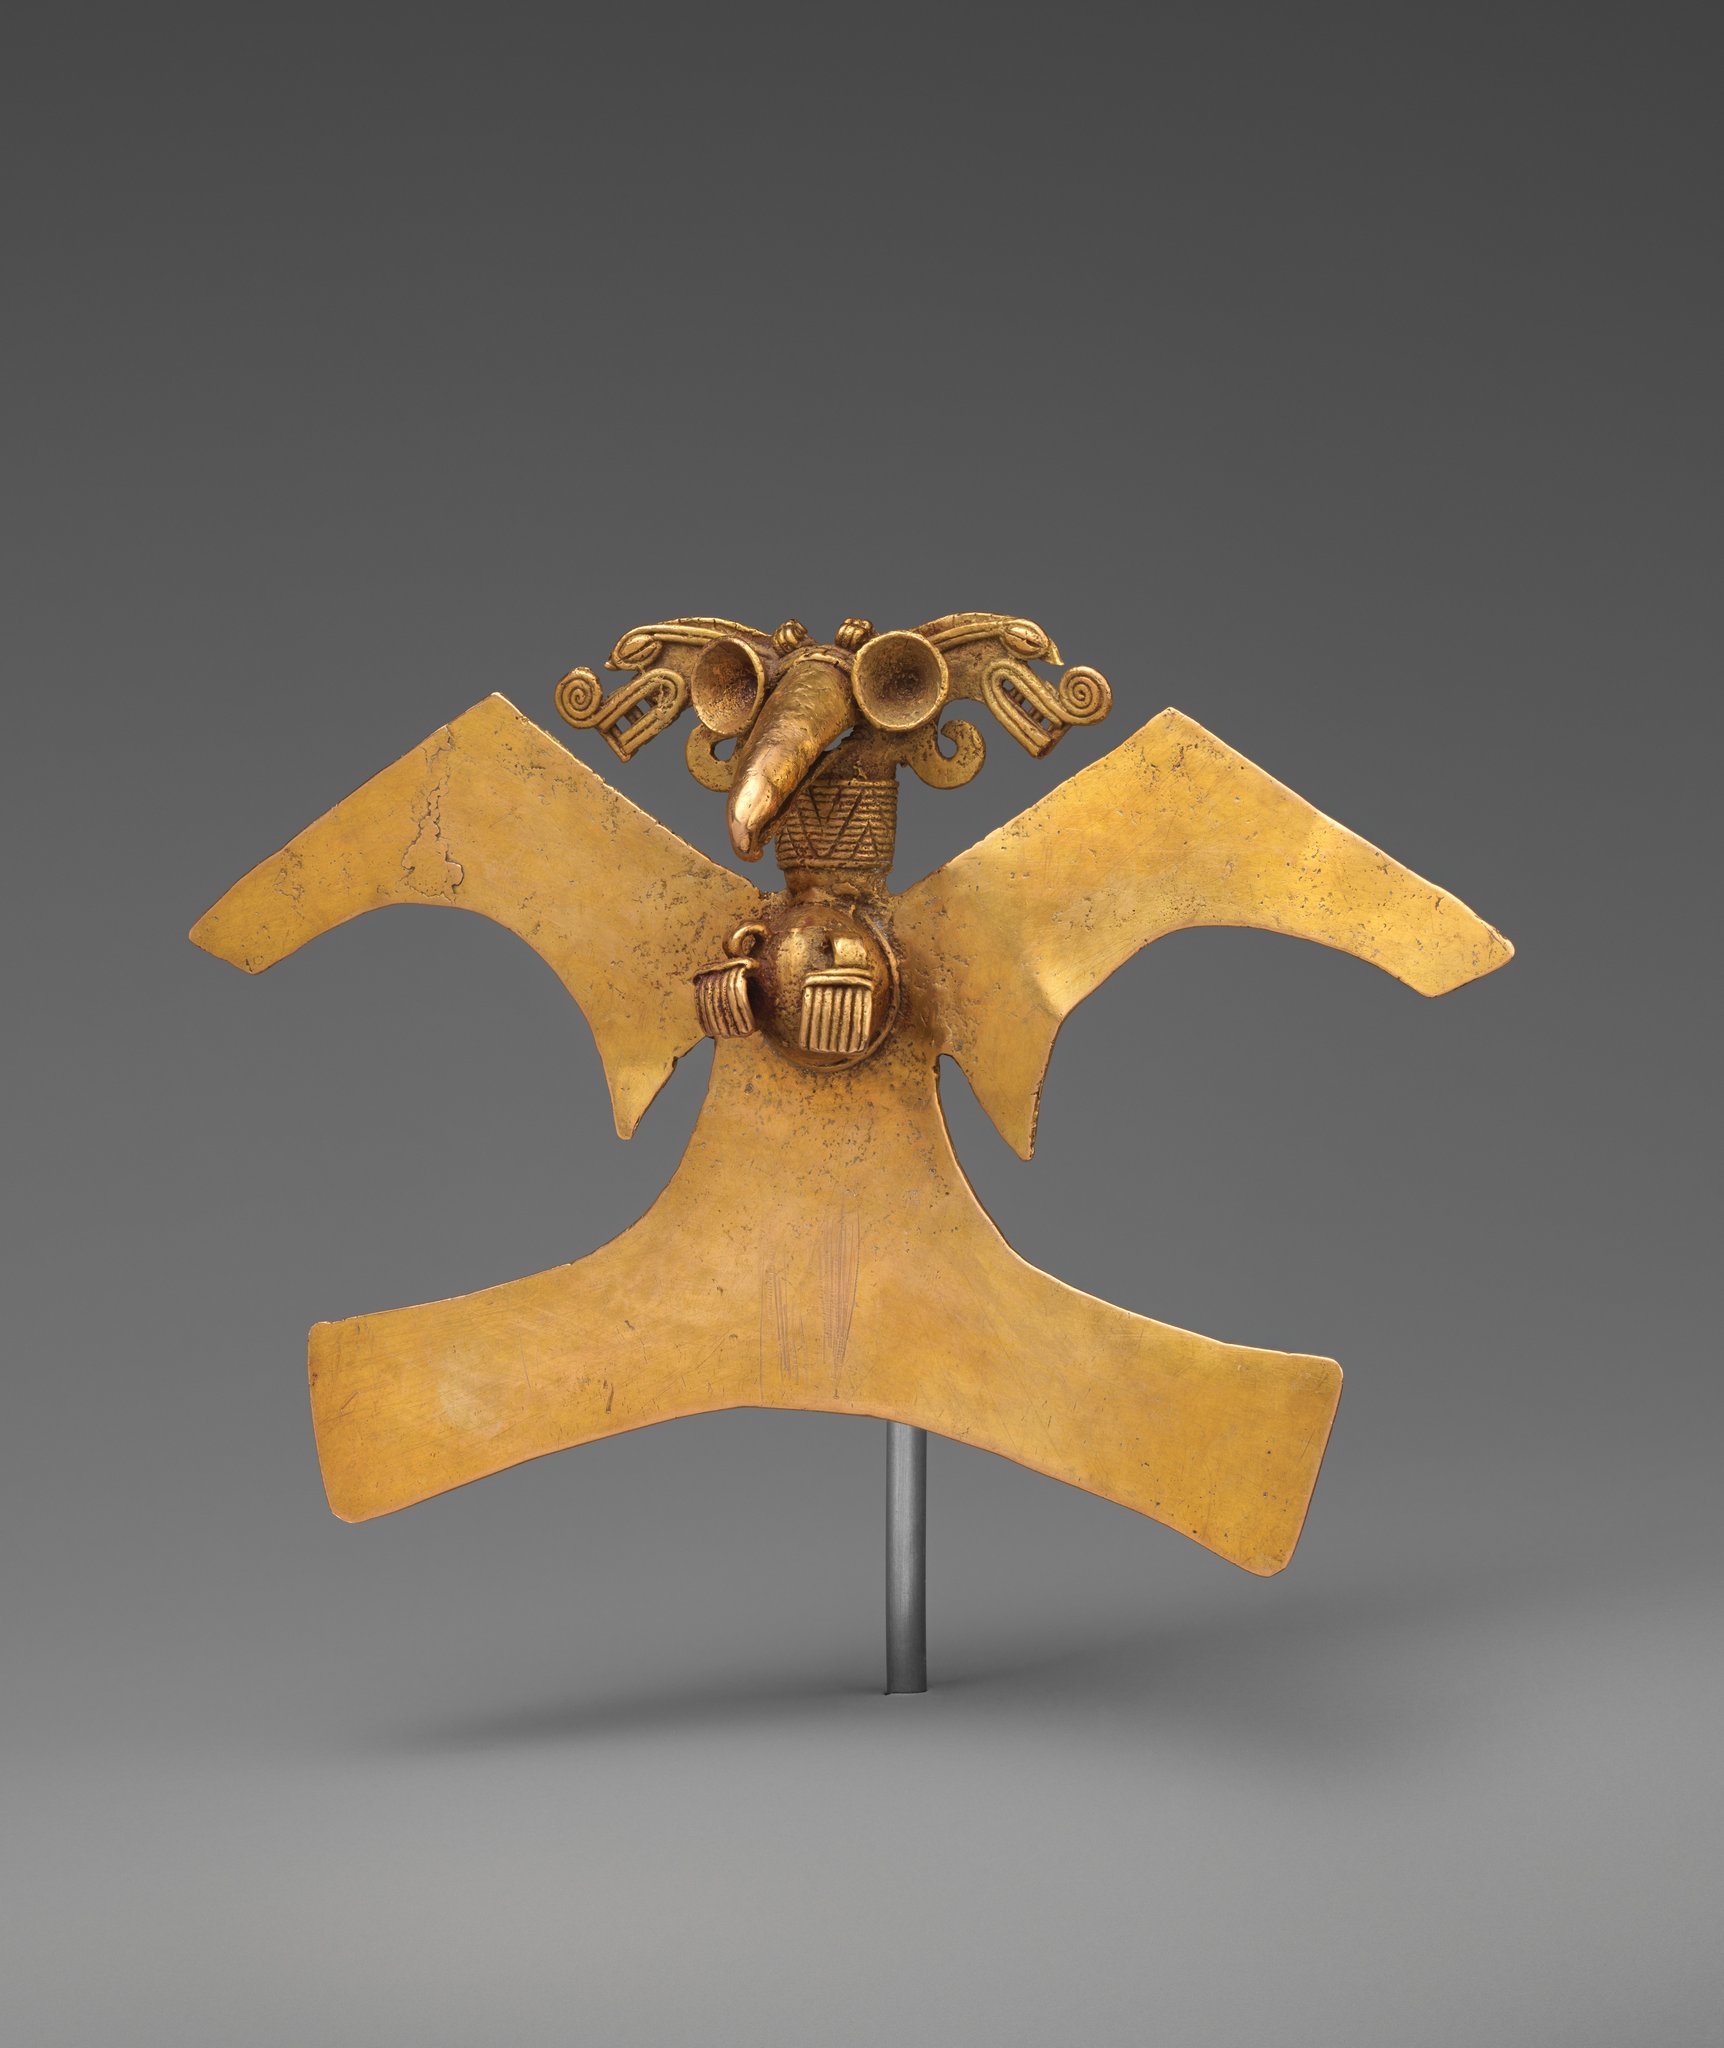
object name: pendant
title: Eagle pendant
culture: veraguas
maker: veraguas artist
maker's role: artist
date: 700-1550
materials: gold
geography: panama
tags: eagles